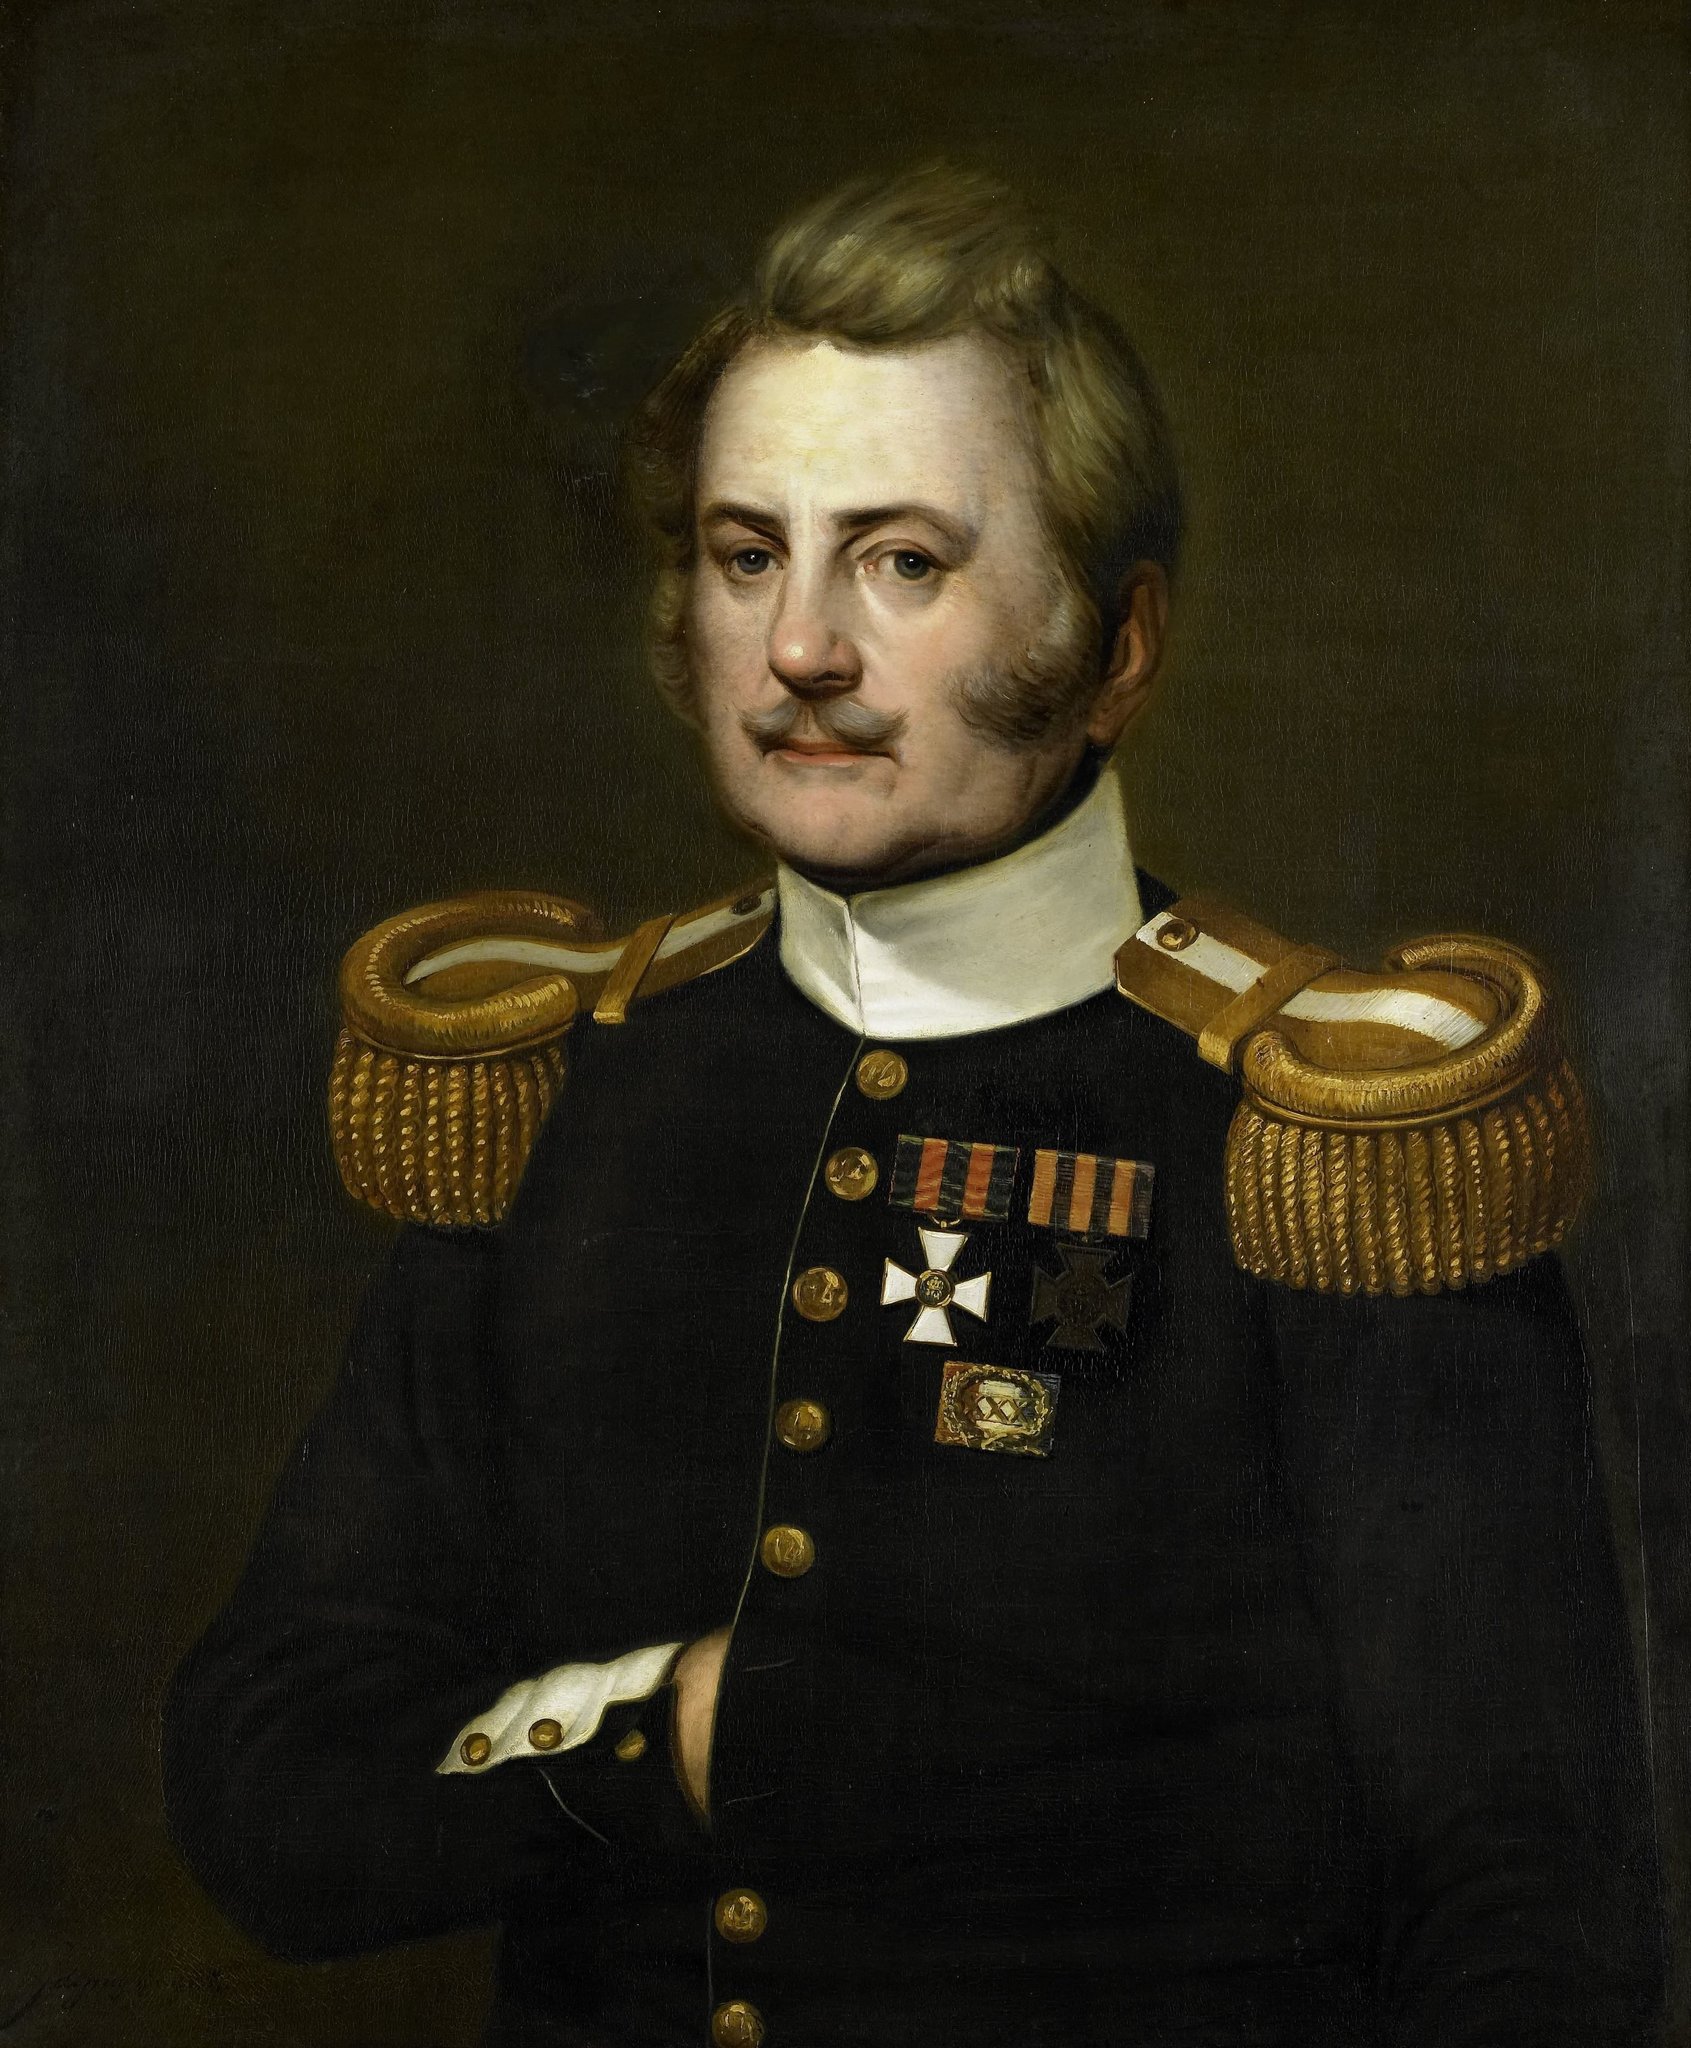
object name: painting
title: J. D. B. Wilkens, Lieutenant Colonel in the Infantry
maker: jurjen de jong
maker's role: painter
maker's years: 1807-1890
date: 1837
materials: canvas, oil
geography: netherlands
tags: amsterdam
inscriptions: signature and date: ‘J. de Jong pinxit 1837’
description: Portret van J.D.B. Wilkens, luitenant-kolonel van de infanterie. Ten halven lijve, de rechterhand in de jas gestoken.